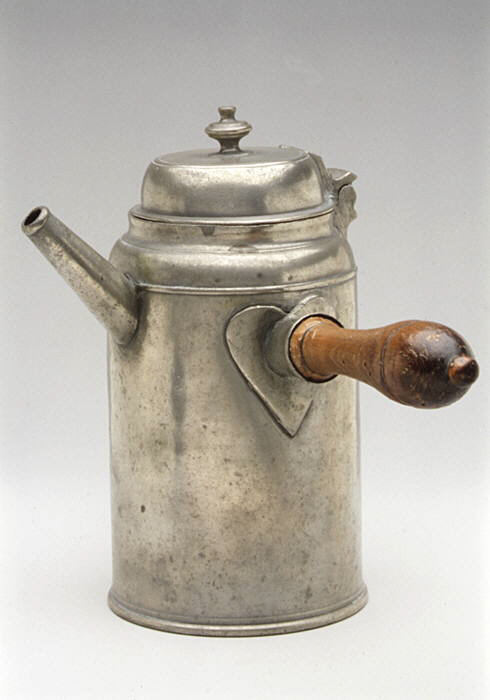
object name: chocolate pot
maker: freidrich gottfried herrmann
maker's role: maker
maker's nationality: german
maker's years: 1783-1813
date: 1806-1813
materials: pewter